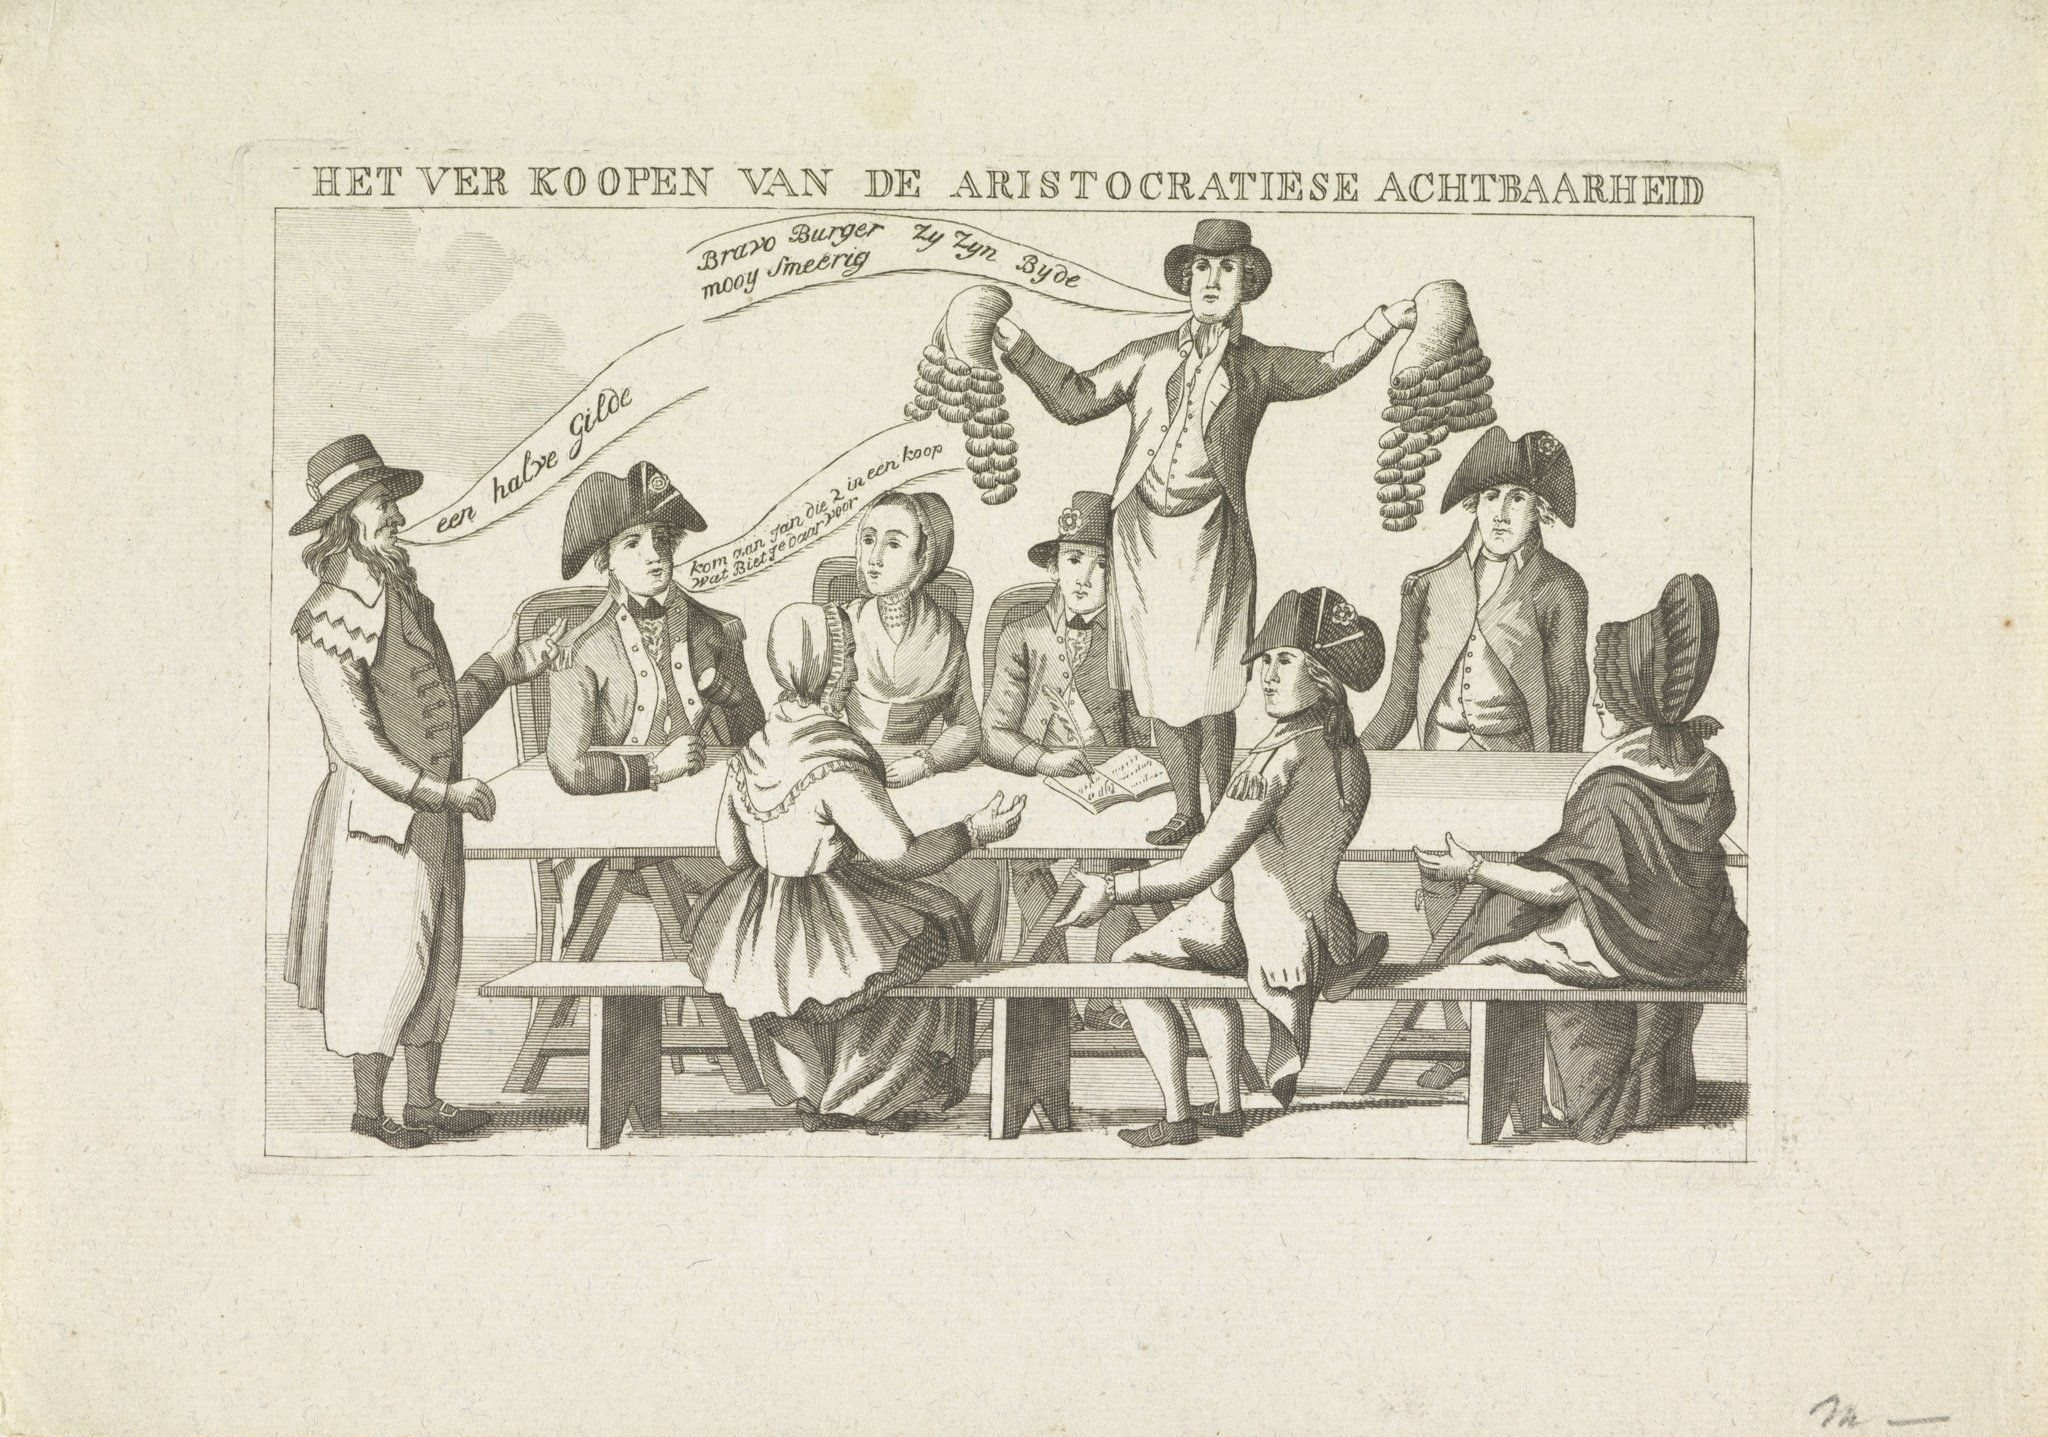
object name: cartoon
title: Spotprent op de Aristocratie (2), 1795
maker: Anonymous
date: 1795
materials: paper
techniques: etching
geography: netherlands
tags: religious and magic concepts, occupations, fashions, realities, general ideas ~ judaism and jewry, aristocracy; 'aristocratia' (ripa), wig, auction sale, public sale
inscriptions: collector's mark: Lugt 2228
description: Spotprent op de Aristocratie, 1795. Openbare verkoping of veiling door Franse soldaten van pruiken. Een verkoper houdt twee pruiken te koop omhoog. Links biedt een staande jood op de pruiken. Zie ook pendant.